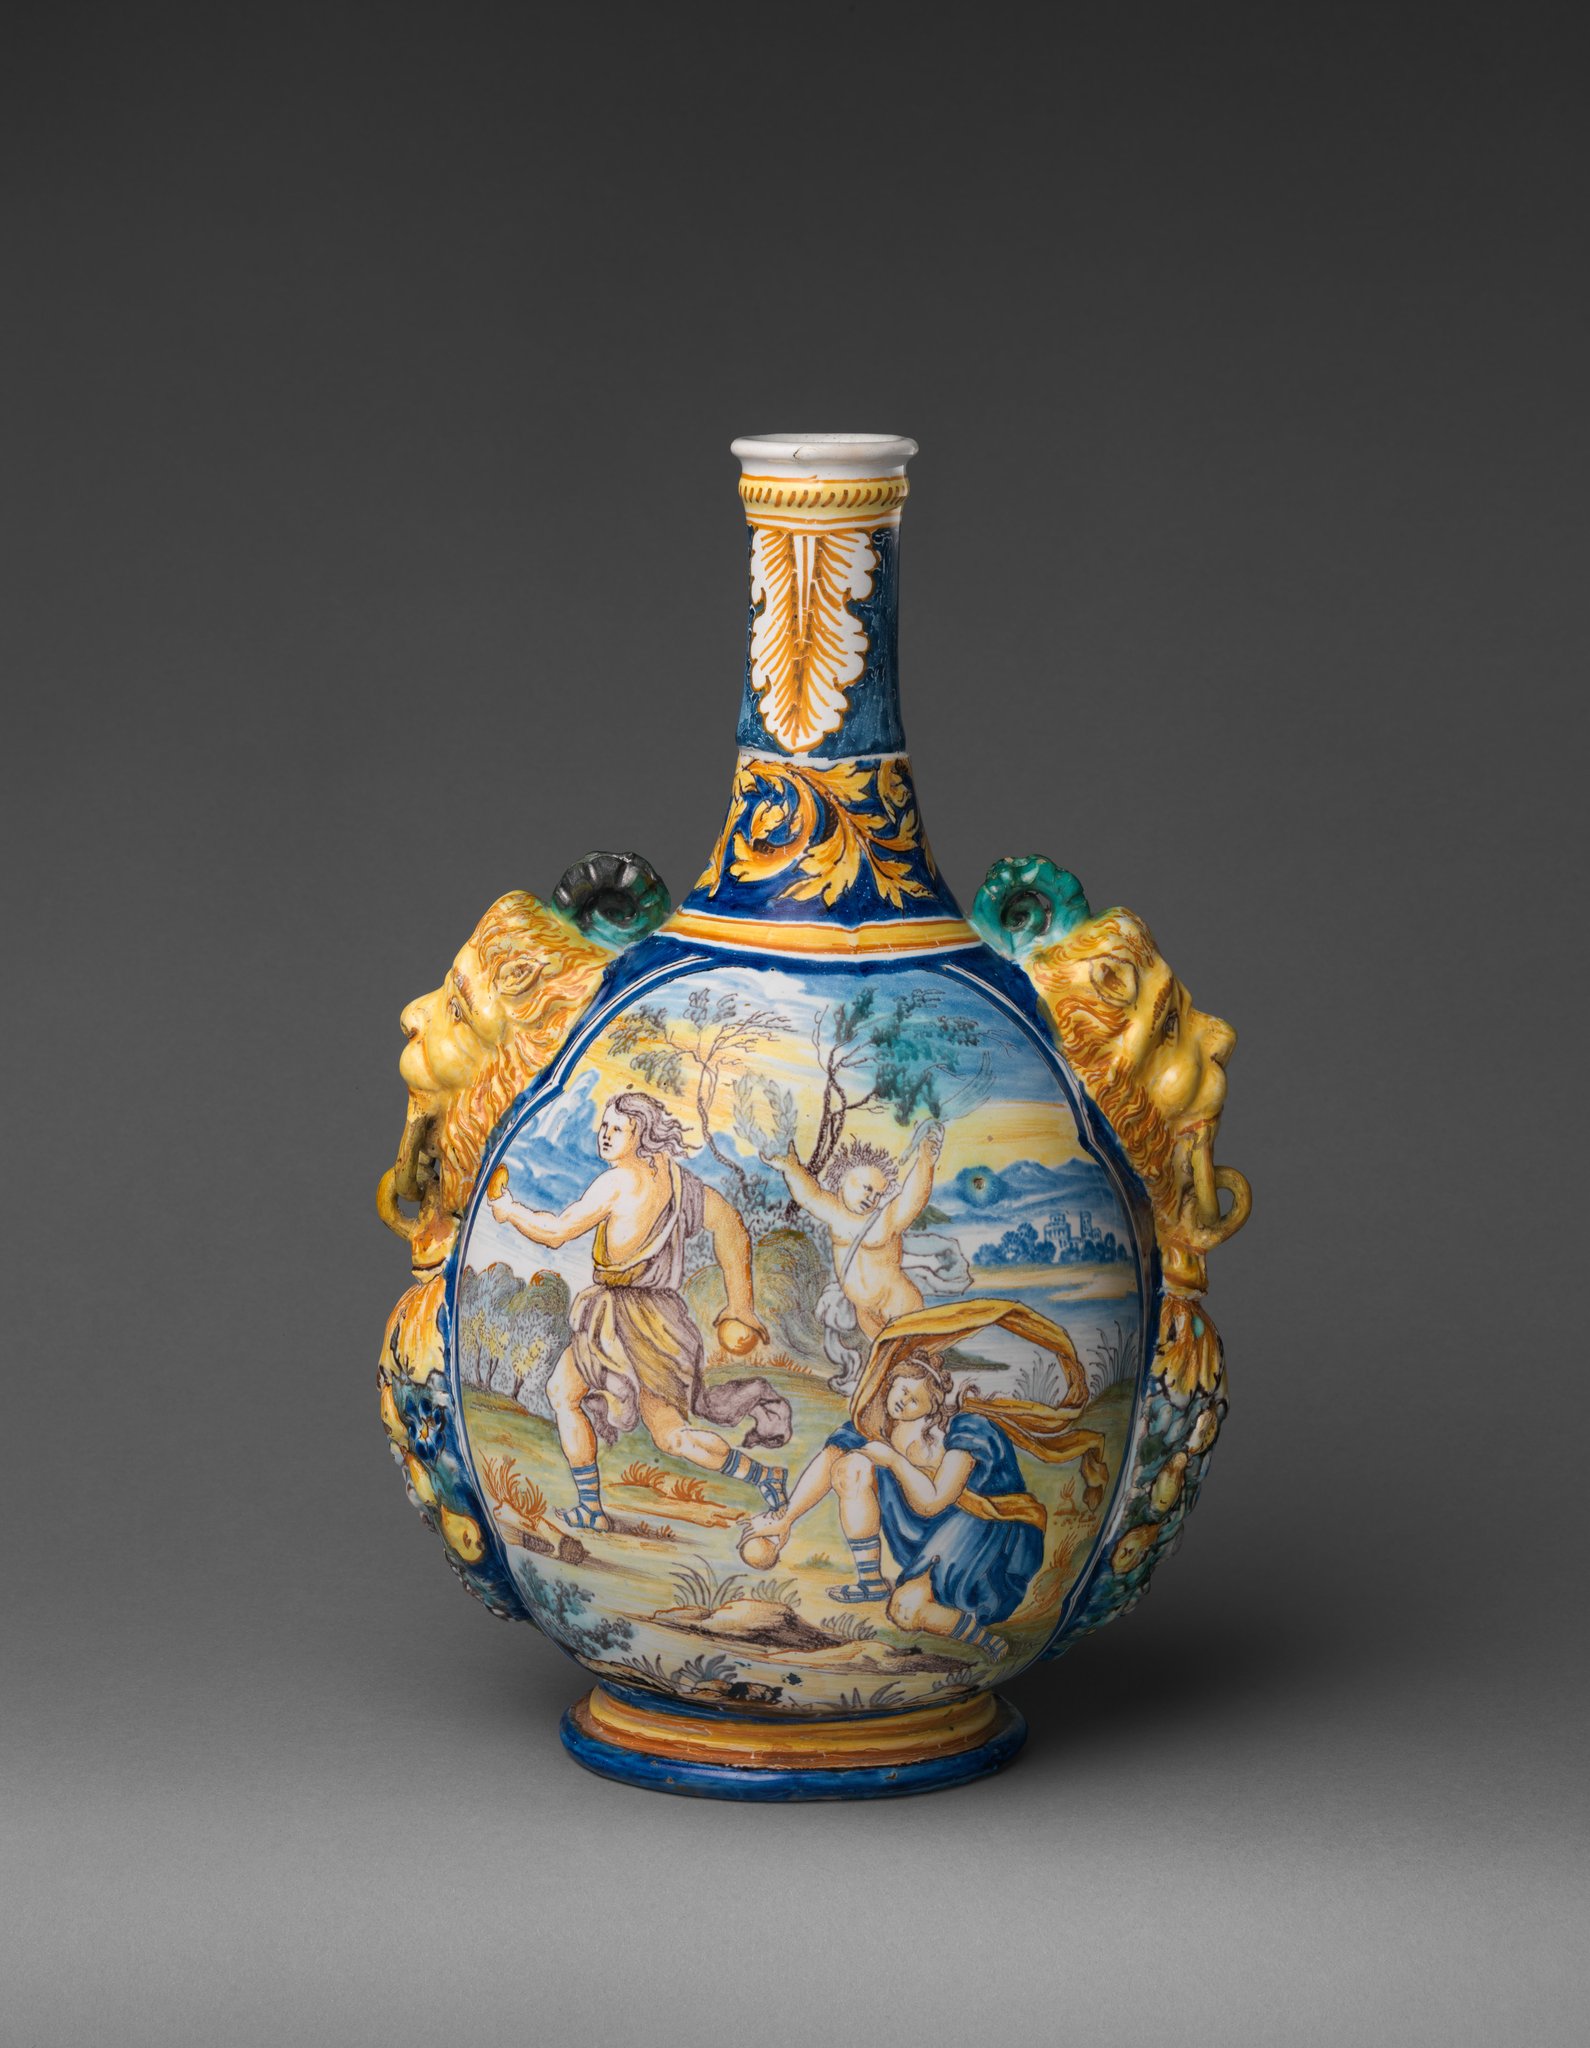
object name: vase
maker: isaac de benserade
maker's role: artist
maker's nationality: french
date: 1680-1700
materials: earthenware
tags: men,women,cupid,lions